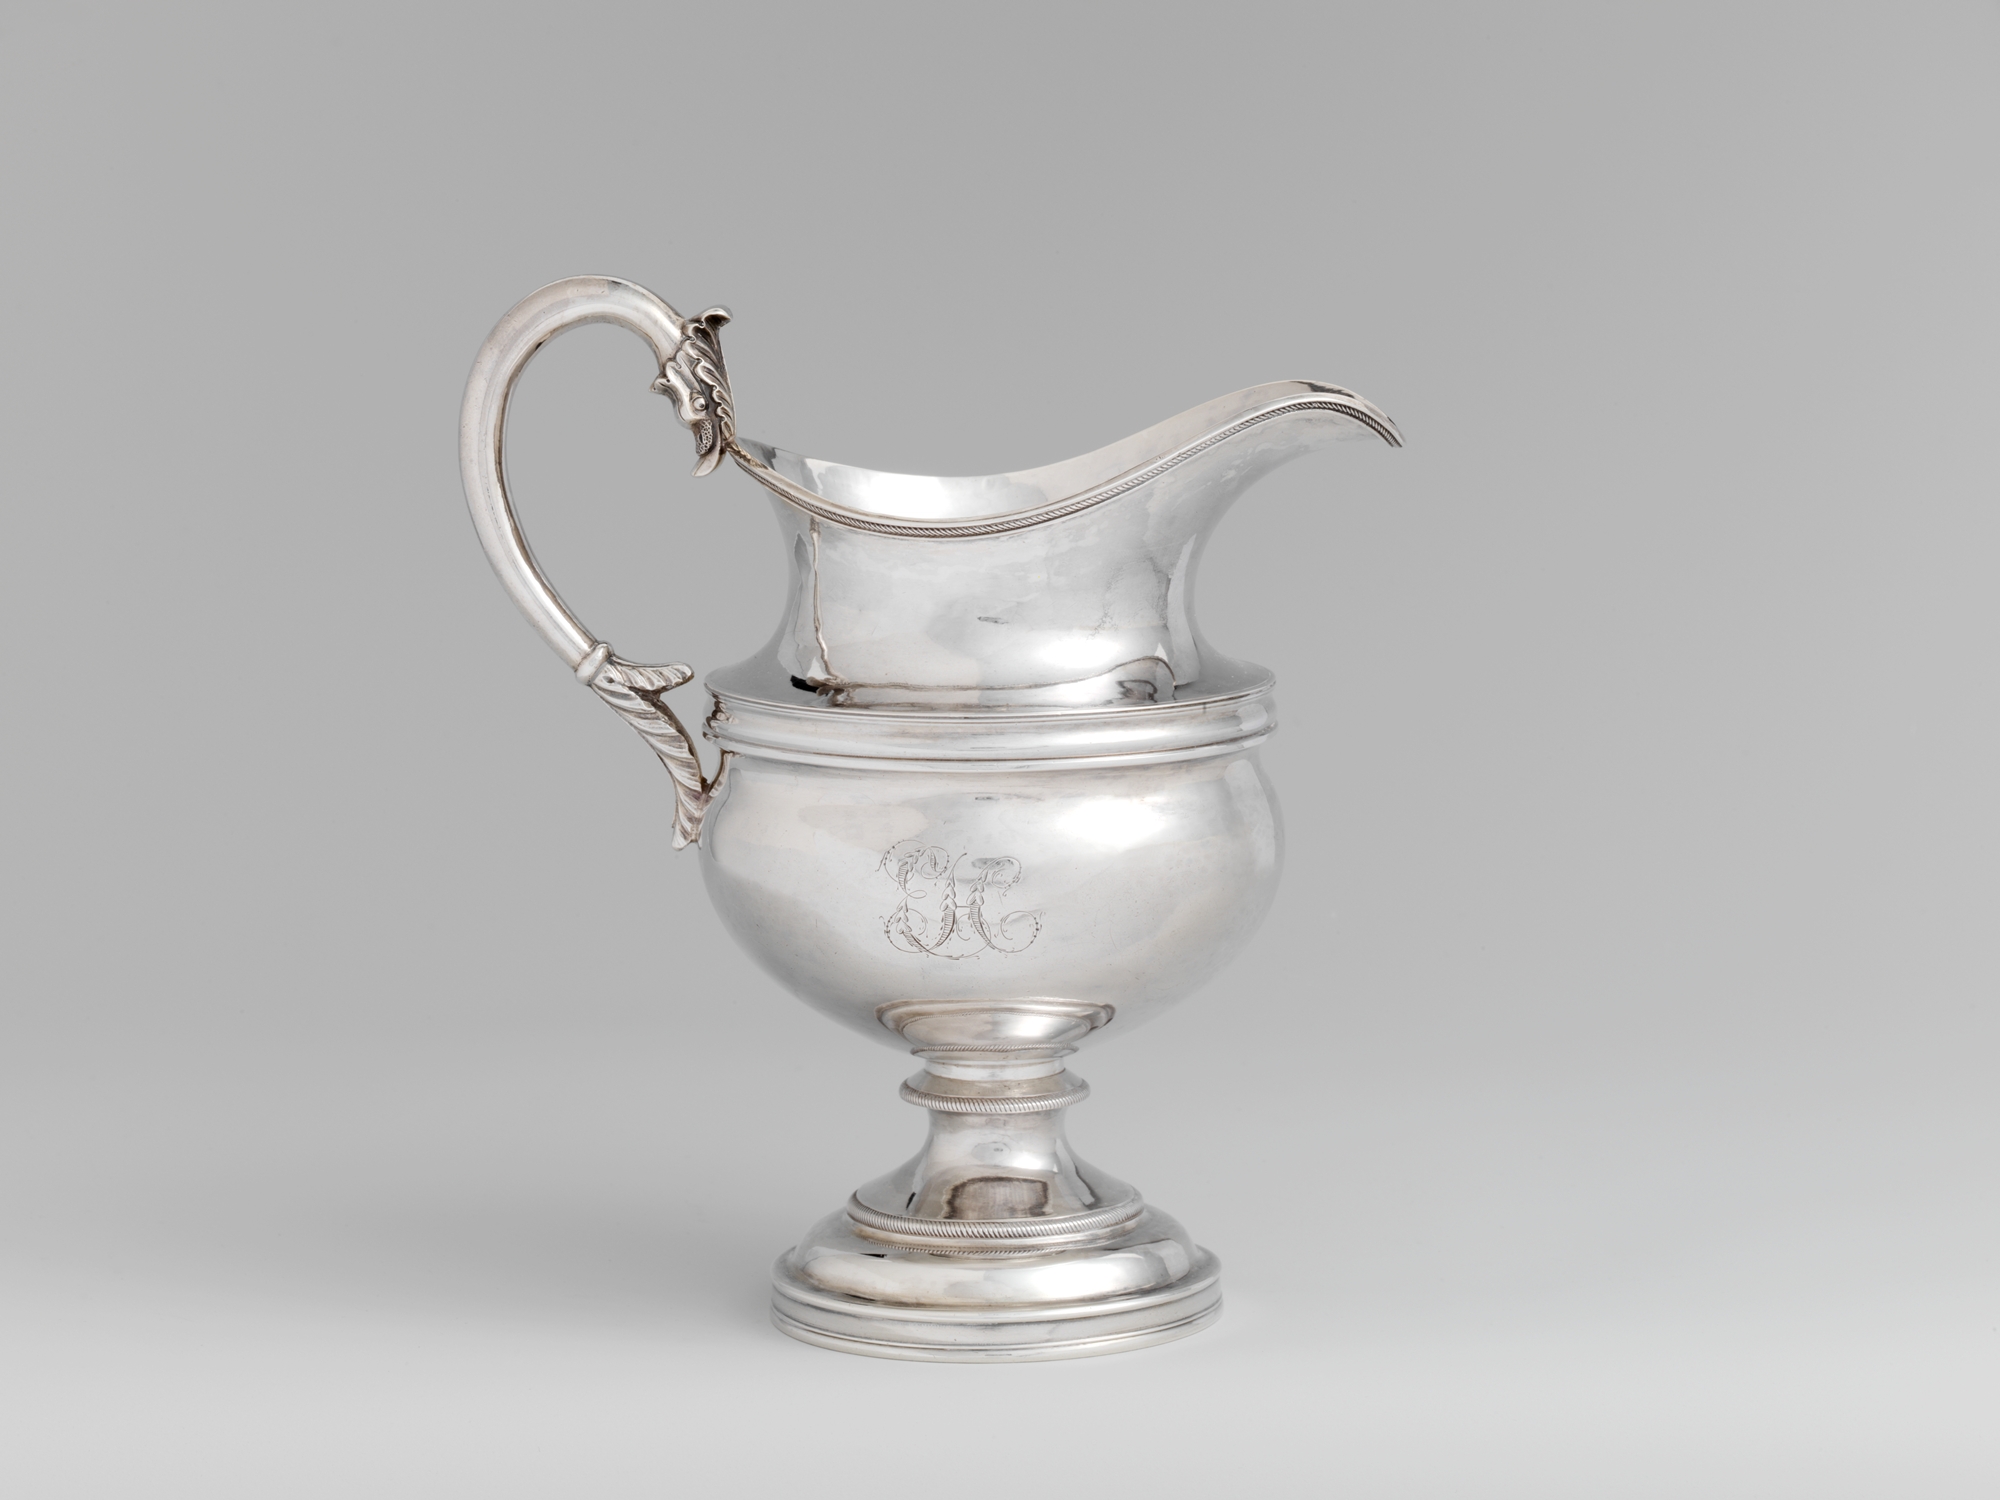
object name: cream pot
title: Creamer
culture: american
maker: harvey lewis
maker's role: maker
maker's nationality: american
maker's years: 1780-1835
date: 1810-1825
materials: silver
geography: united states